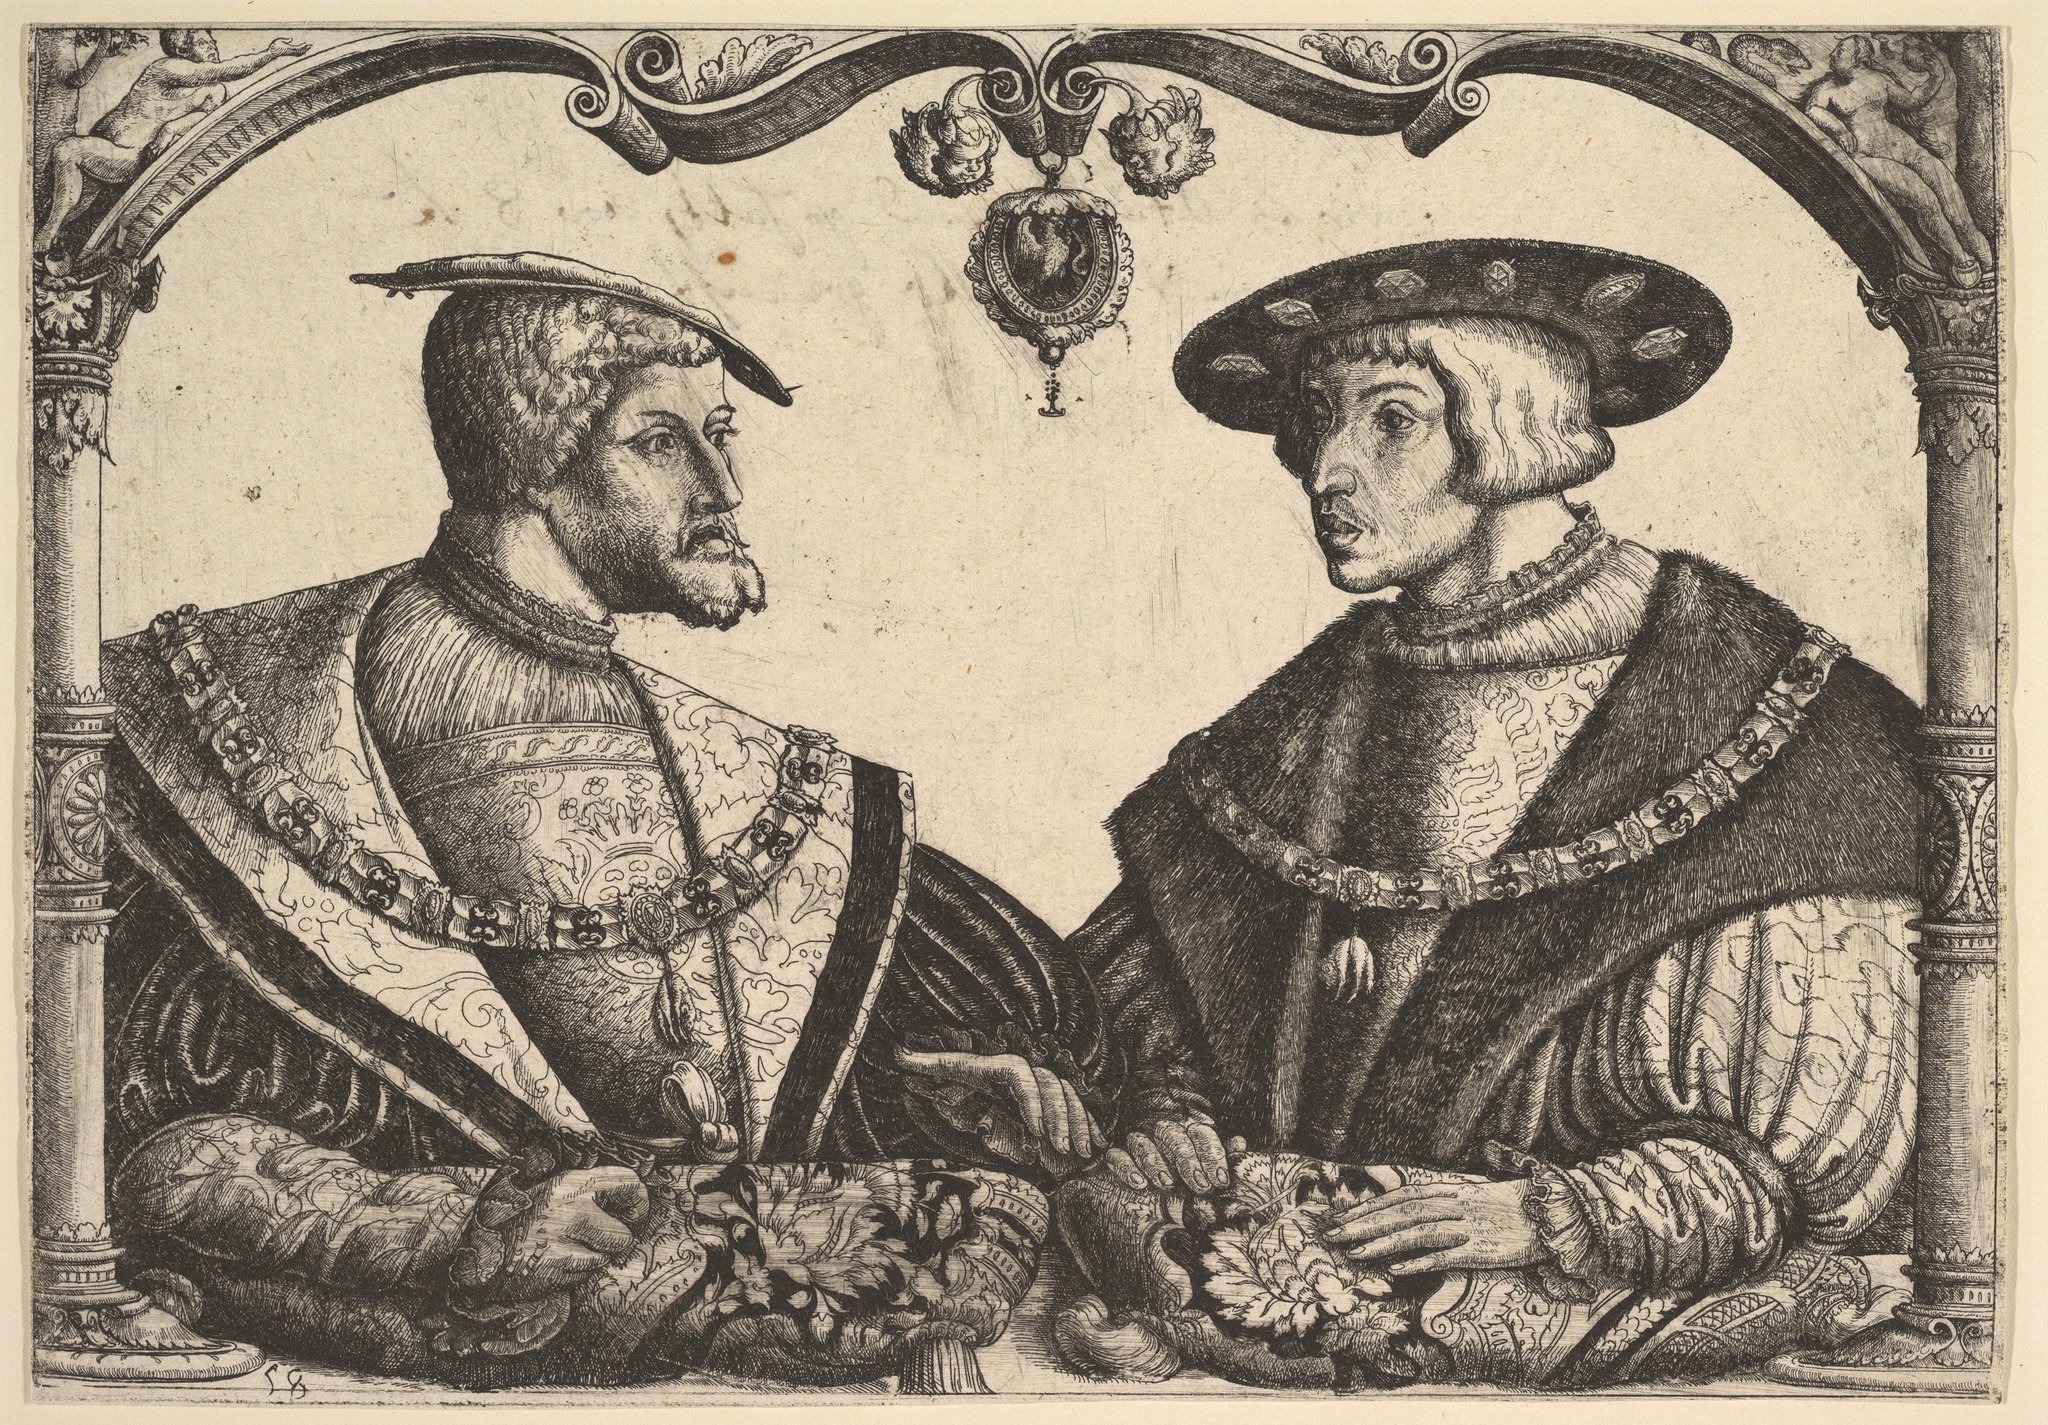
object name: print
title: Emperors Charles V and Ferdinand I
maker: christoph bockstorffer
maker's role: artist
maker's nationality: german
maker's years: 1475-1558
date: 1531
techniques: etching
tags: men,portraits